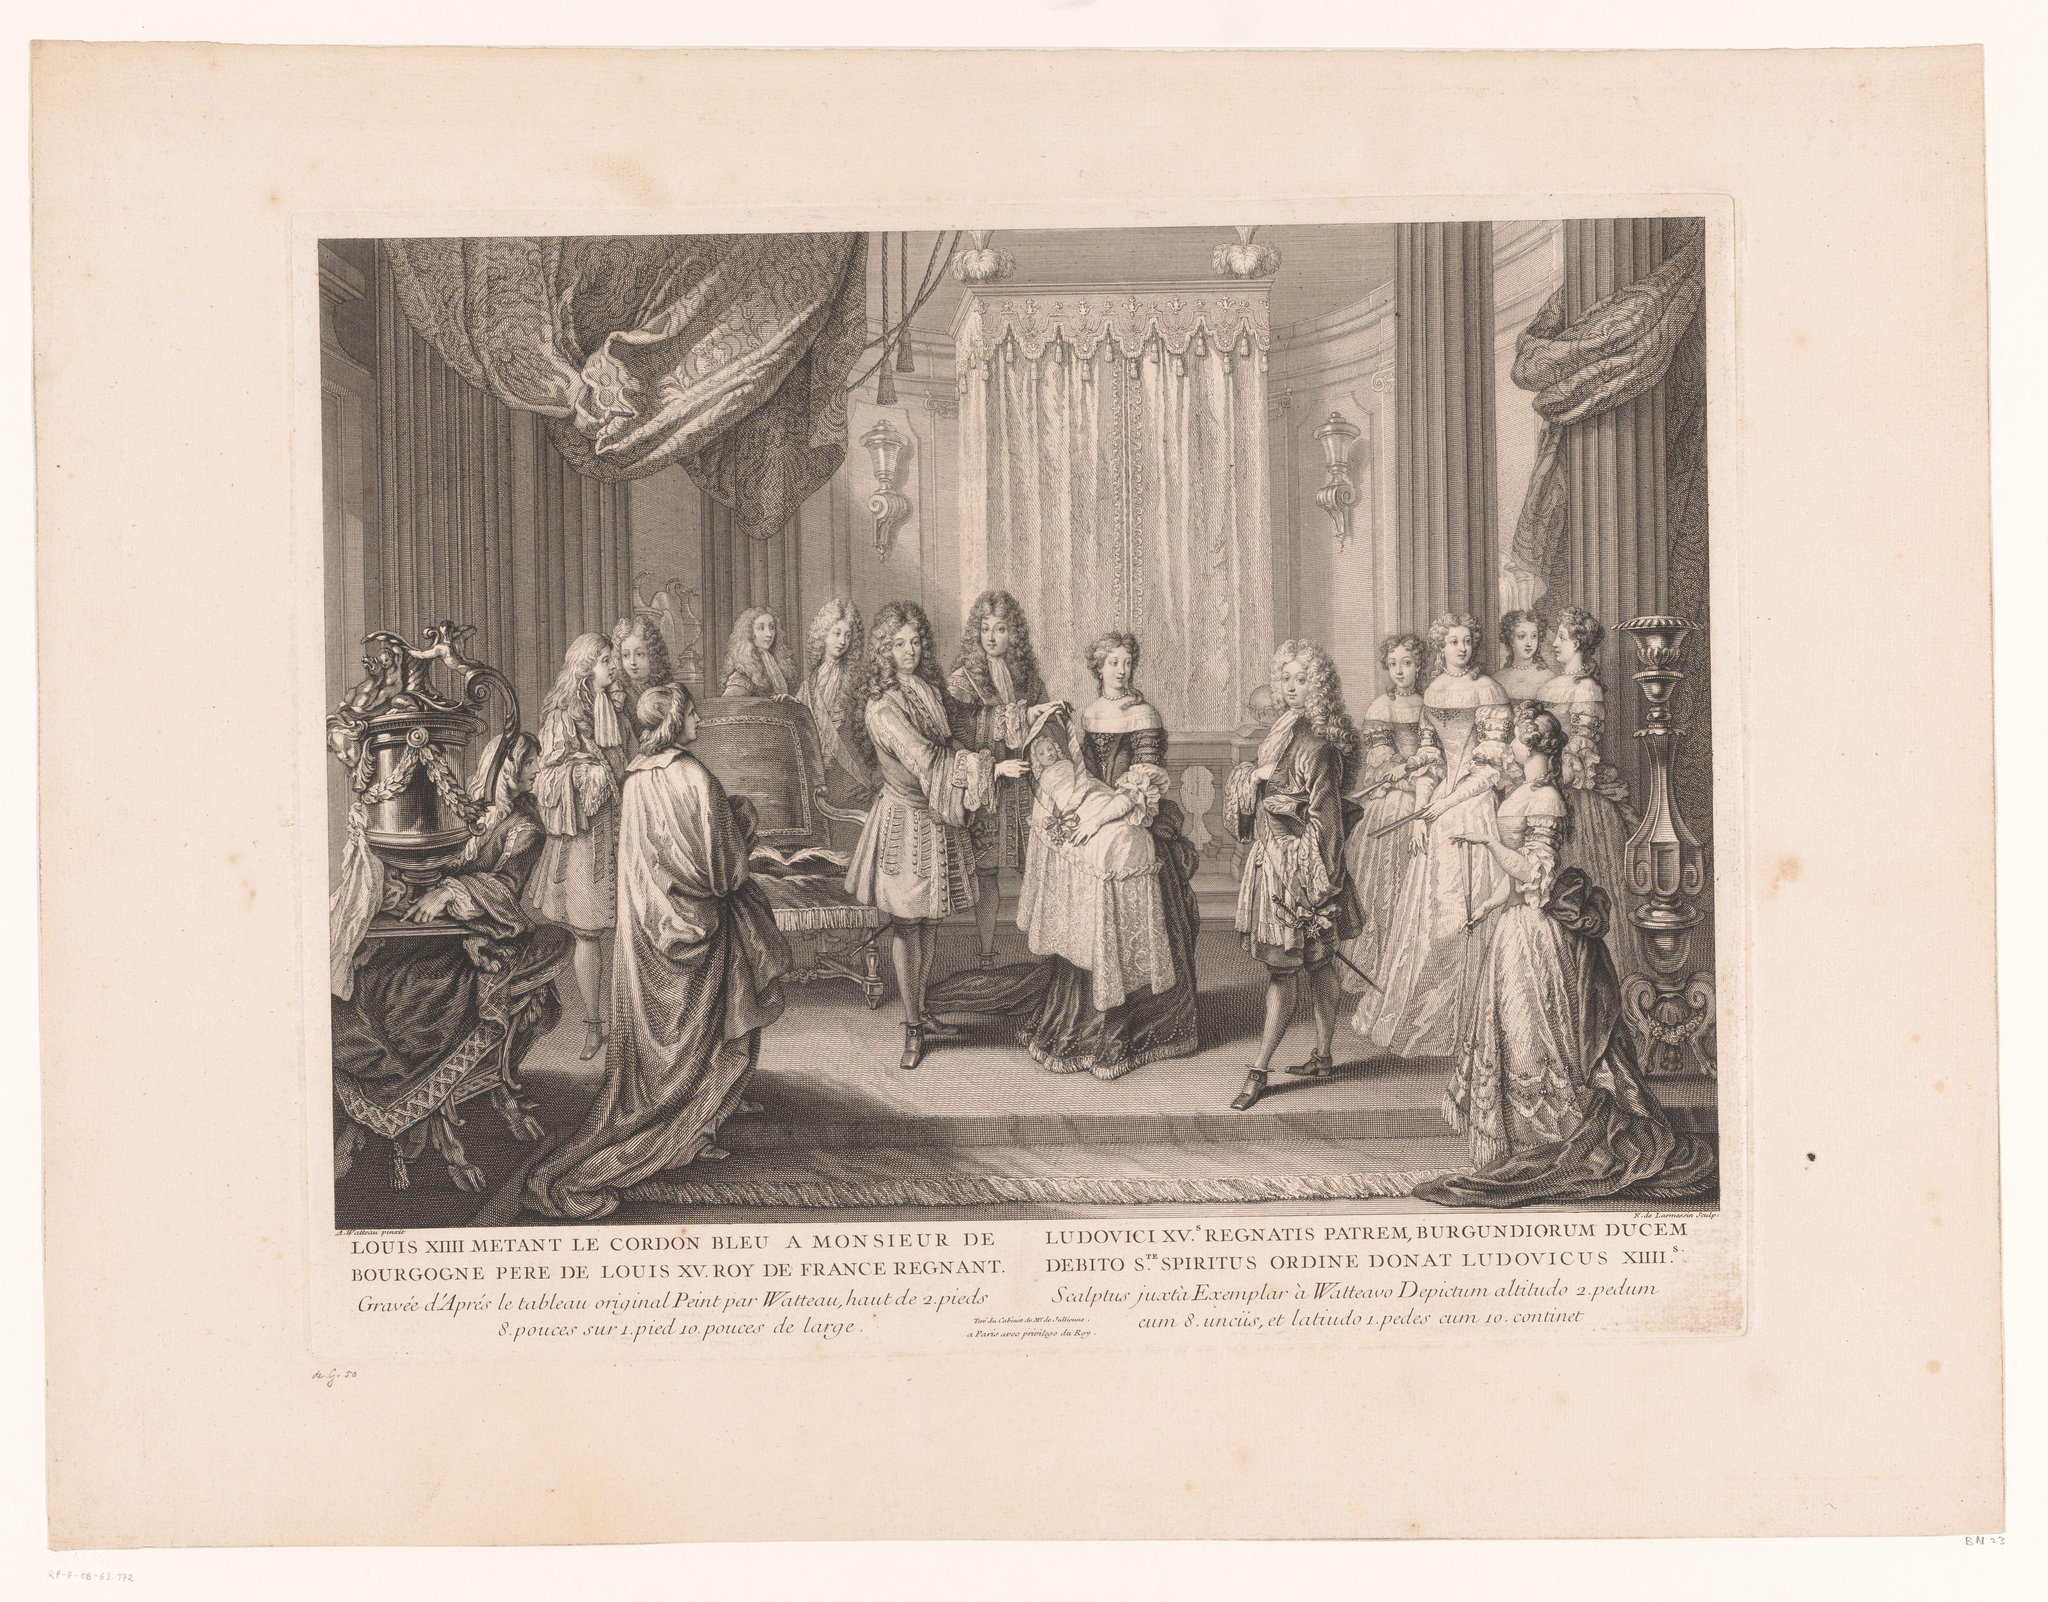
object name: print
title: Lodewijk XIV van Frankrijk decoreert de hertog van Bourgogne met het blauwe lint van de Orde van de Heilige Geest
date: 1729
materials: paper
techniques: engraving, etching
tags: lodewijk xiv (koning van frankrijk), historical persons, knighthood order of the holy spirit - insignia of a knighthood order, e.g.: badge, chain (with name of order)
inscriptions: watermark, collector's mark: Lugt 2228